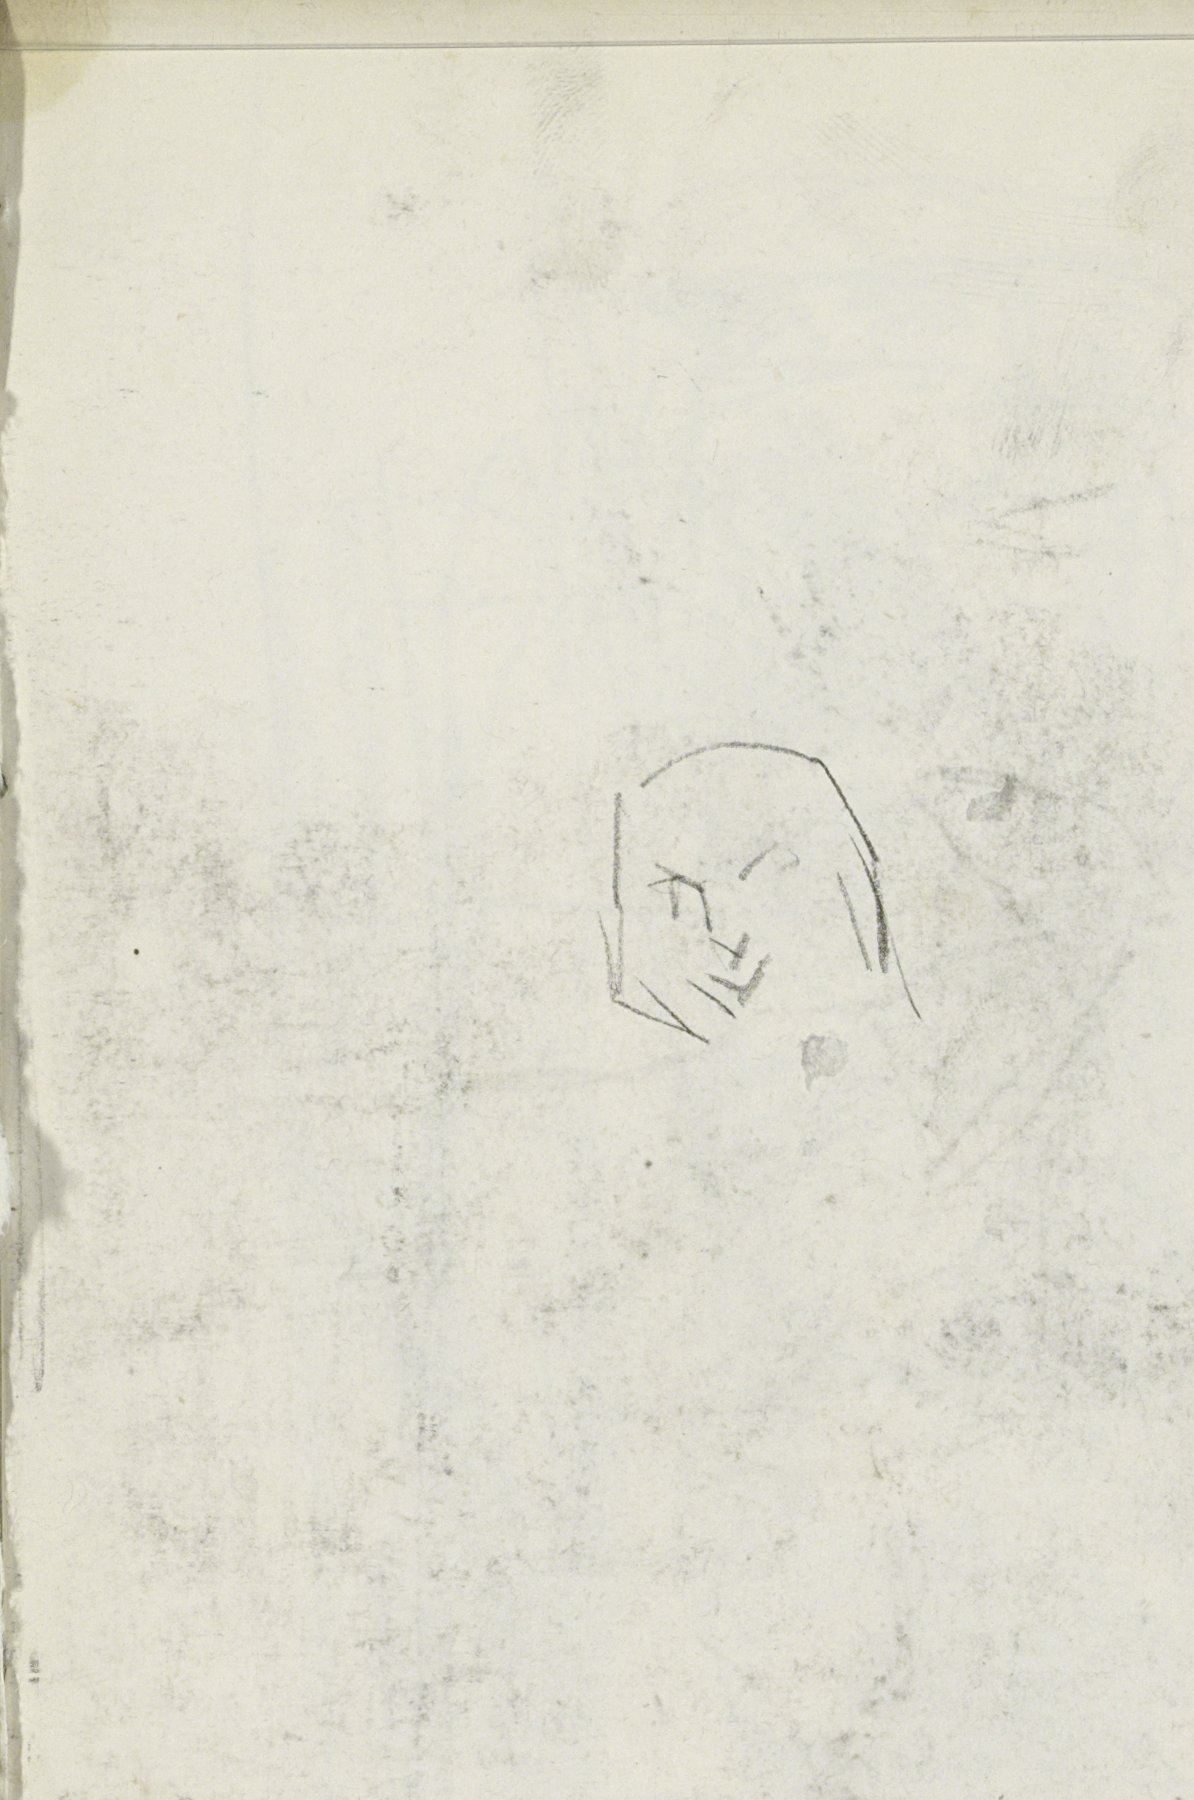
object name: sketchbook leaf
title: Hoofd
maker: isaac israels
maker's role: draughtsman, painter, print maker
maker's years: 1865-1934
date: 1875-1934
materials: chalk, paper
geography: london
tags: head (human)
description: Pagina 21 en pagina 22 uit schetsboek XXXV met 36 pagina's.